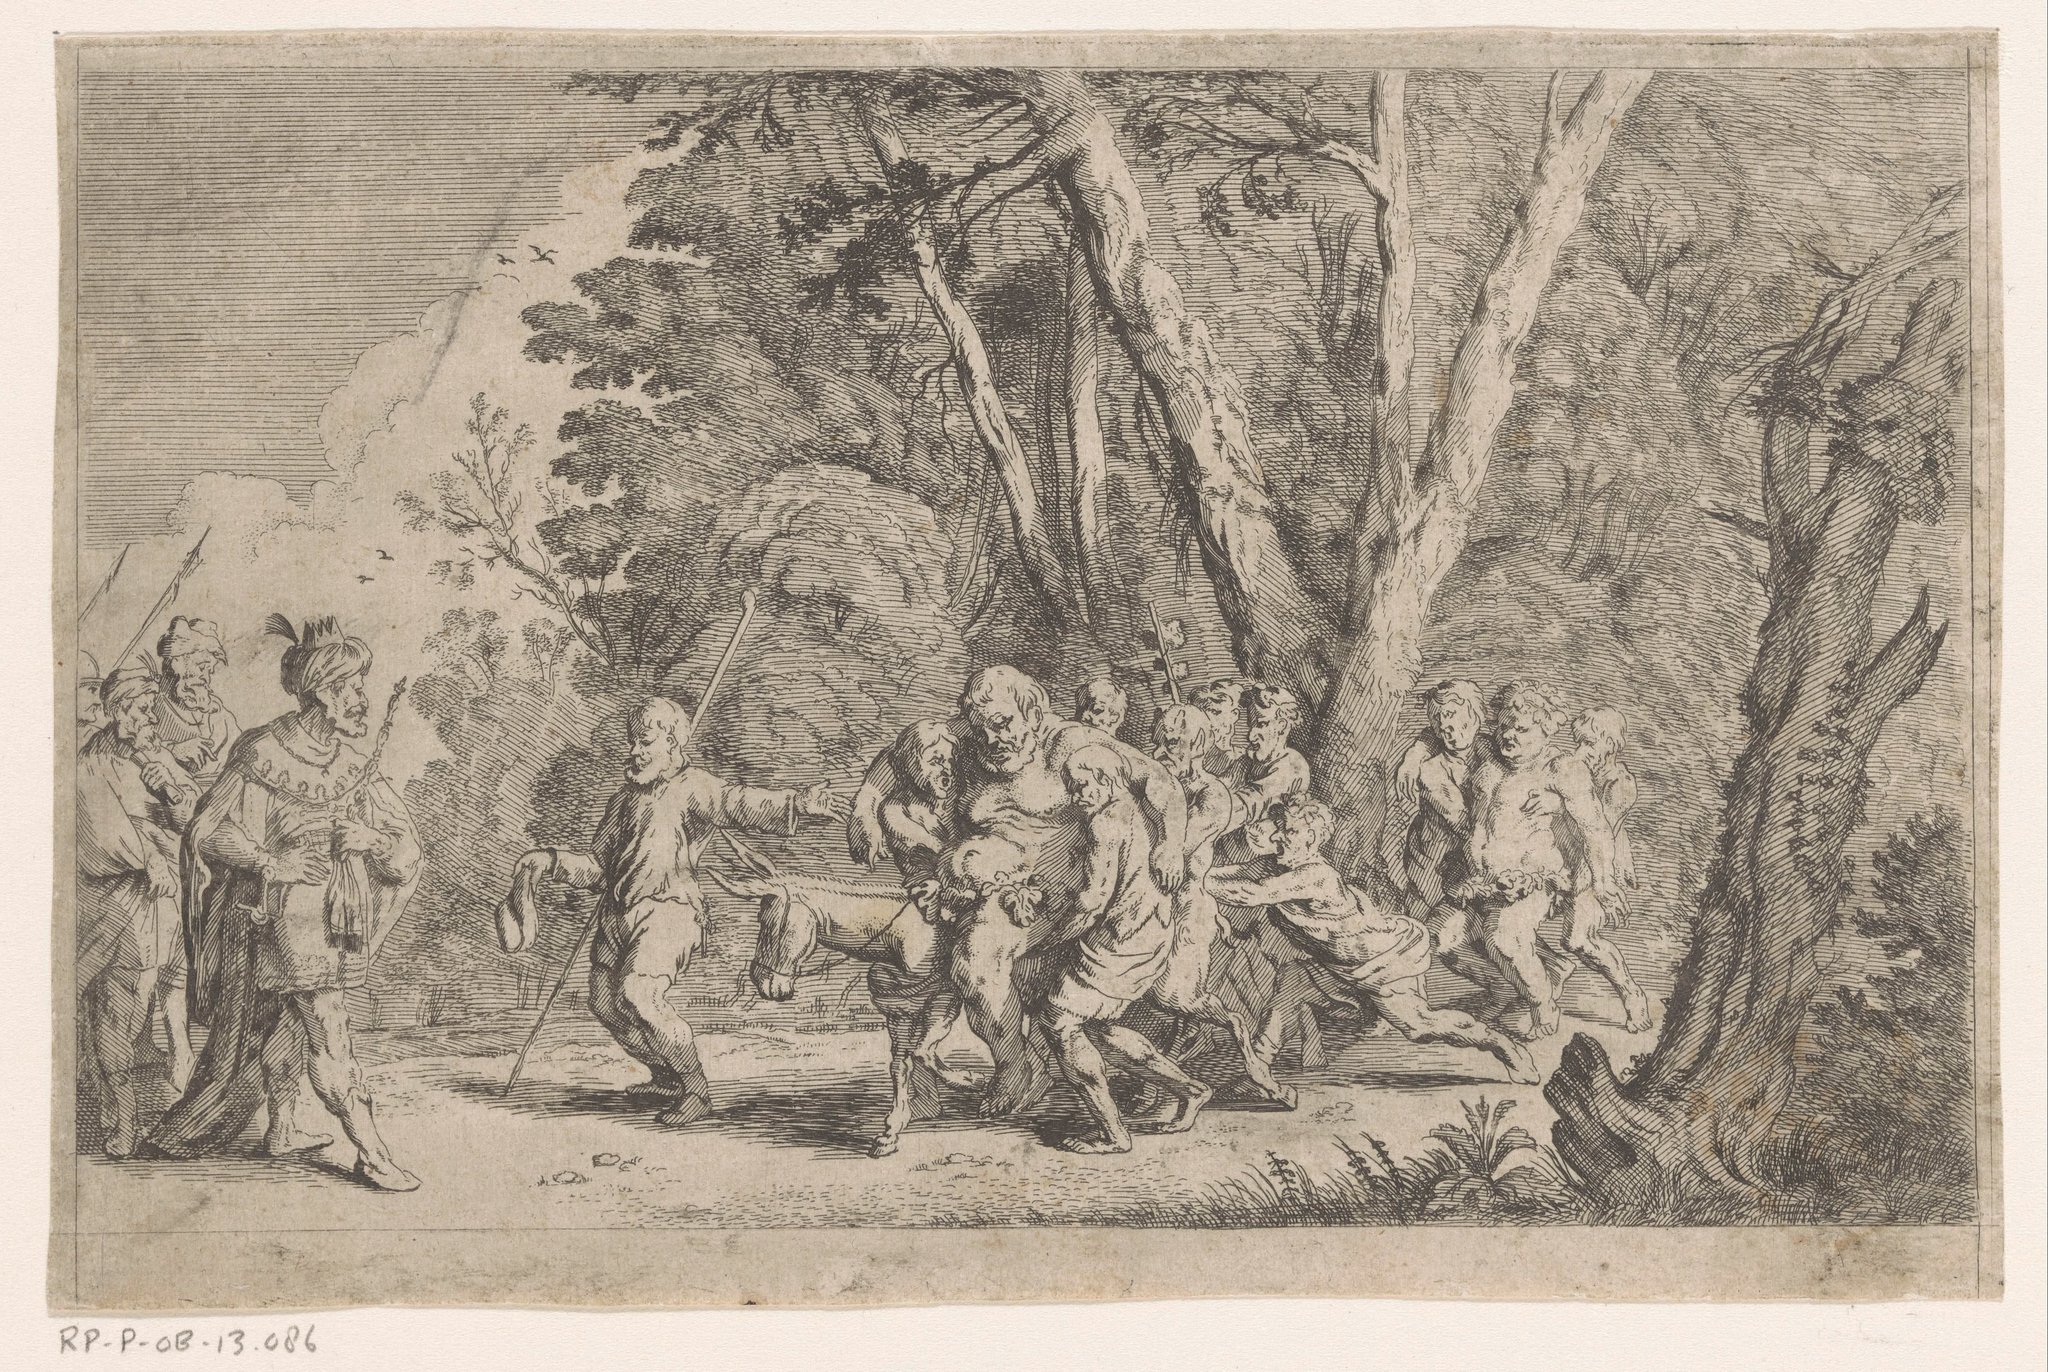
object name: print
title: Silenus voor koning Midas gebracht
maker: Anonymous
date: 1639-1700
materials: paper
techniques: etching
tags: silenus amicably entertained by midas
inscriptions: collector's mark: Lugt 240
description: Anonieme kopie naar een prent uit de serie 'Metamorfosen van Ovidius', bestaand uit 150 prenten en een titelprent, uitgegeven tussen 1639-1641.